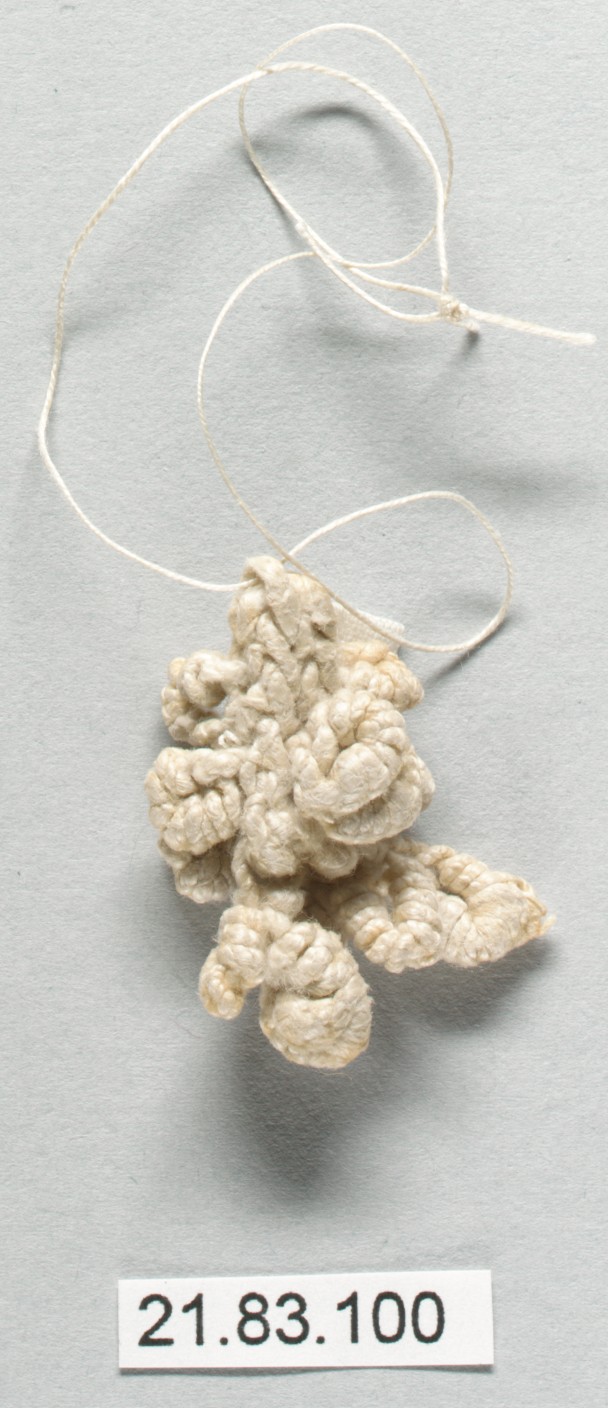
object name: tassel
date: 1601-1700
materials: linen